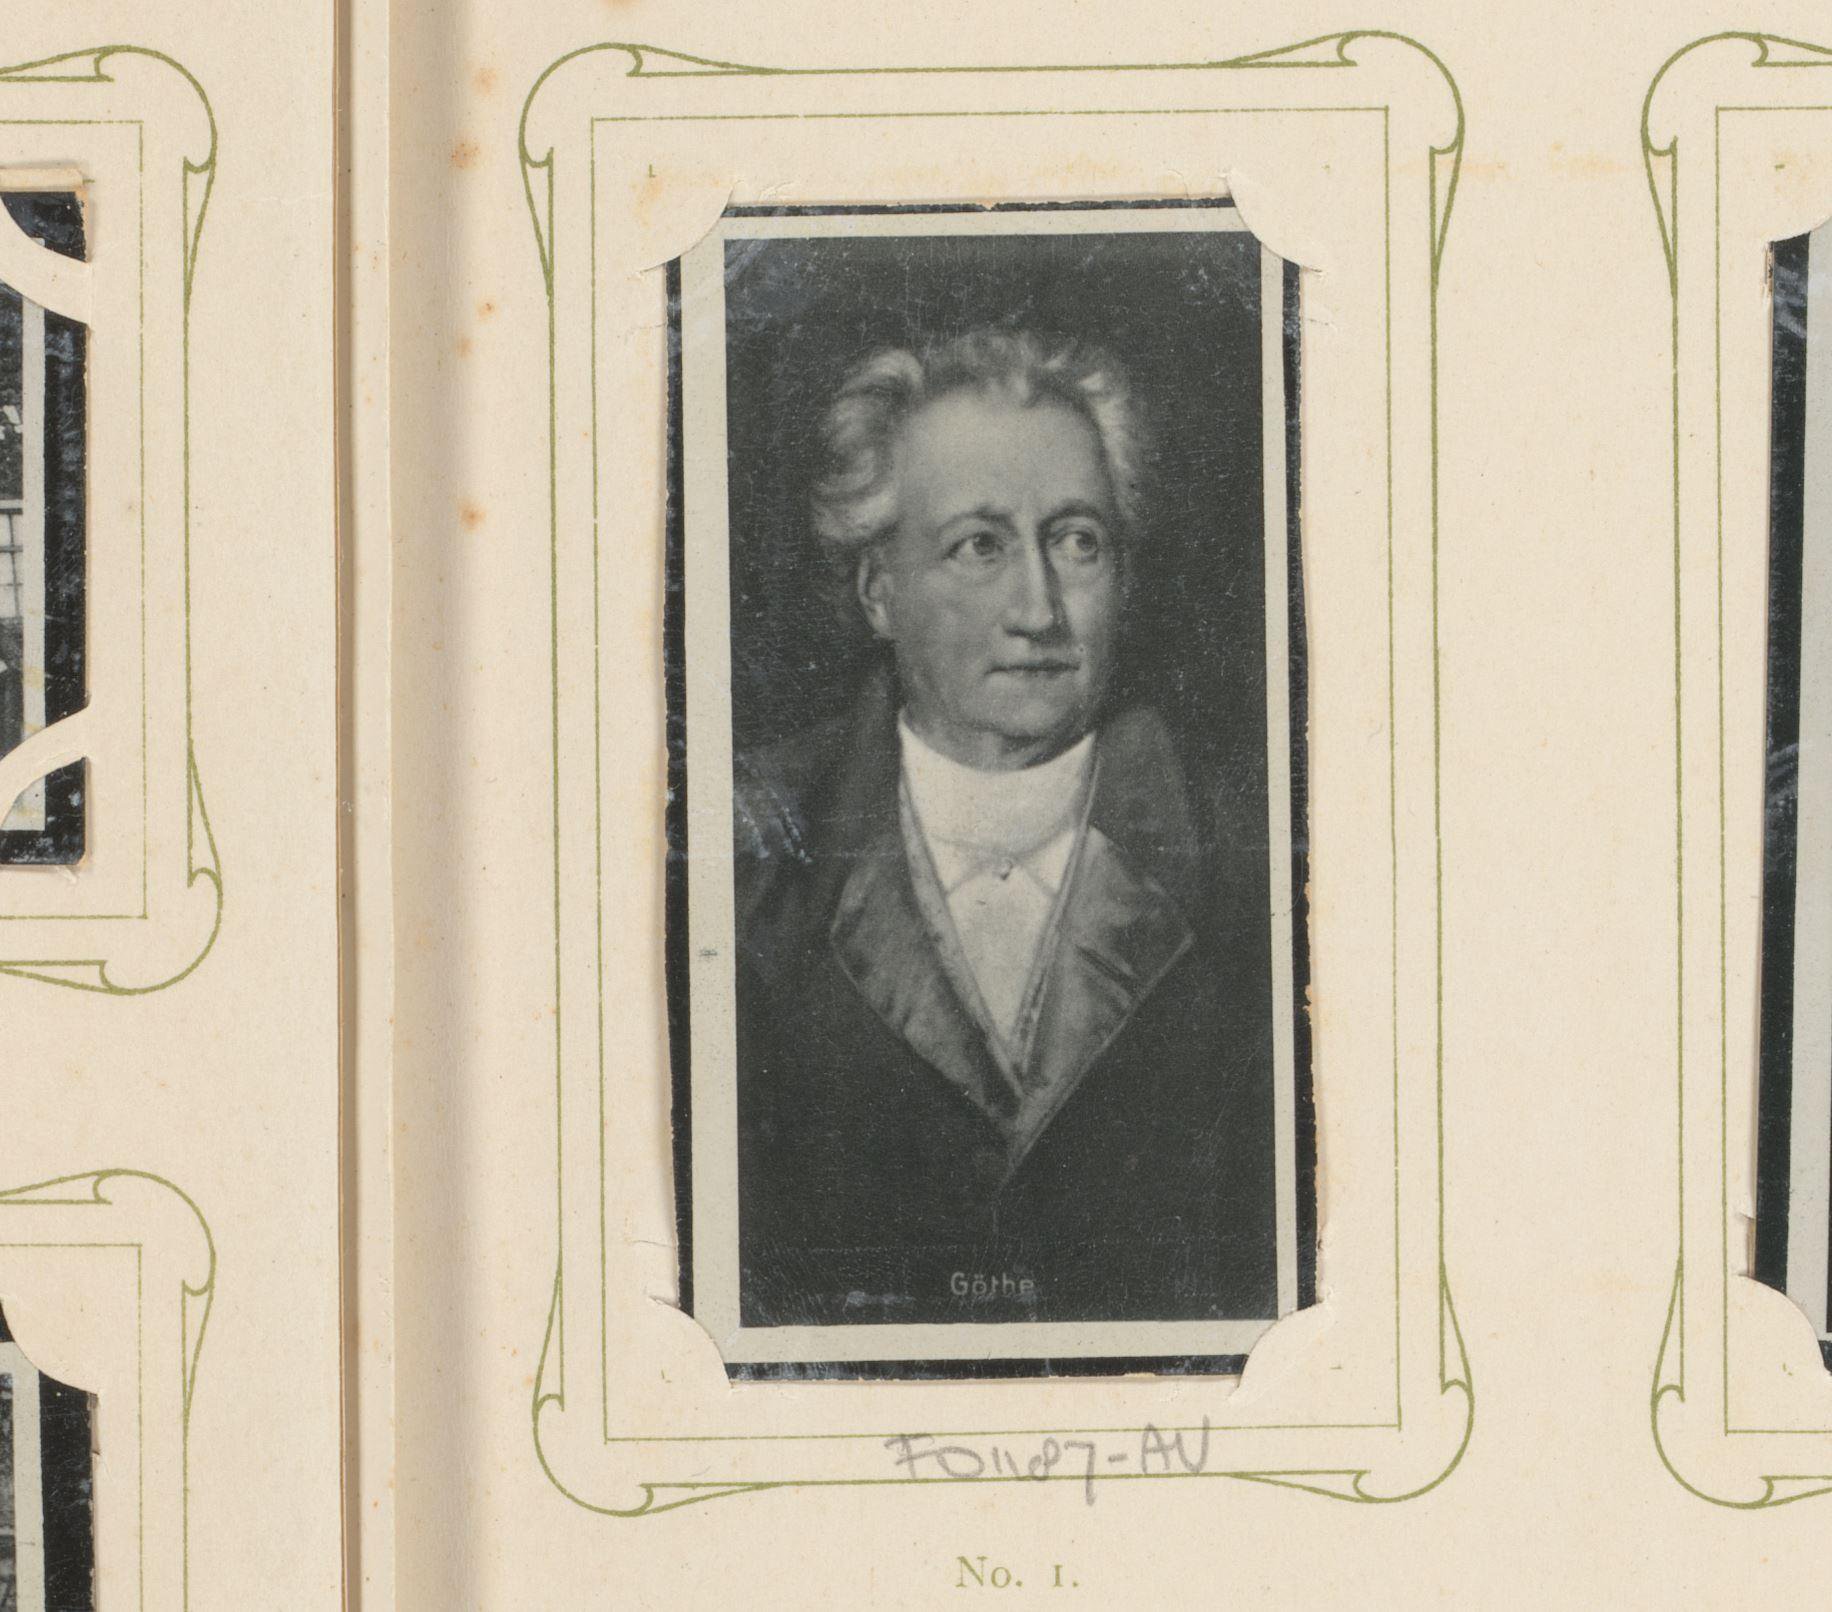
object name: photomechanical print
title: Reproductie van een geschilderd portret van Johann Wolfgang von Goethe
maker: Anonymous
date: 1905-1906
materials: paper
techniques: photograph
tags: draughtsman, johann wolfgang von goethe, historical persons, portrait of a writer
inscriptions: inscription: ‘No. 1./ Göthe.’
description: Deze prent maakt deel uit van een album.